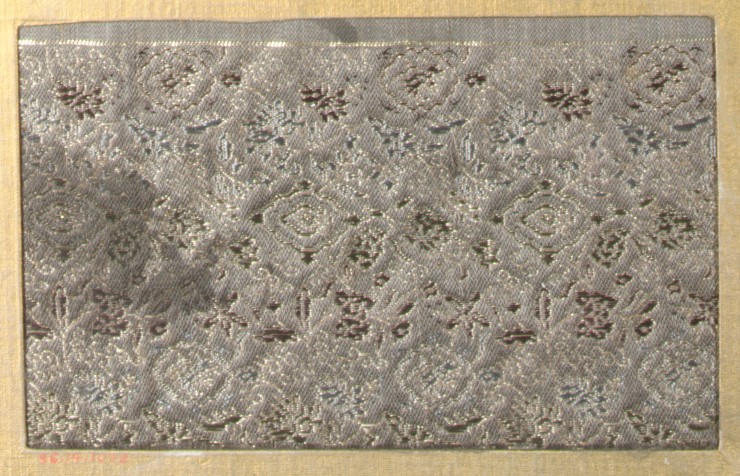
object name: piece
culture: japanese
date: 1701-1900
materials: silk